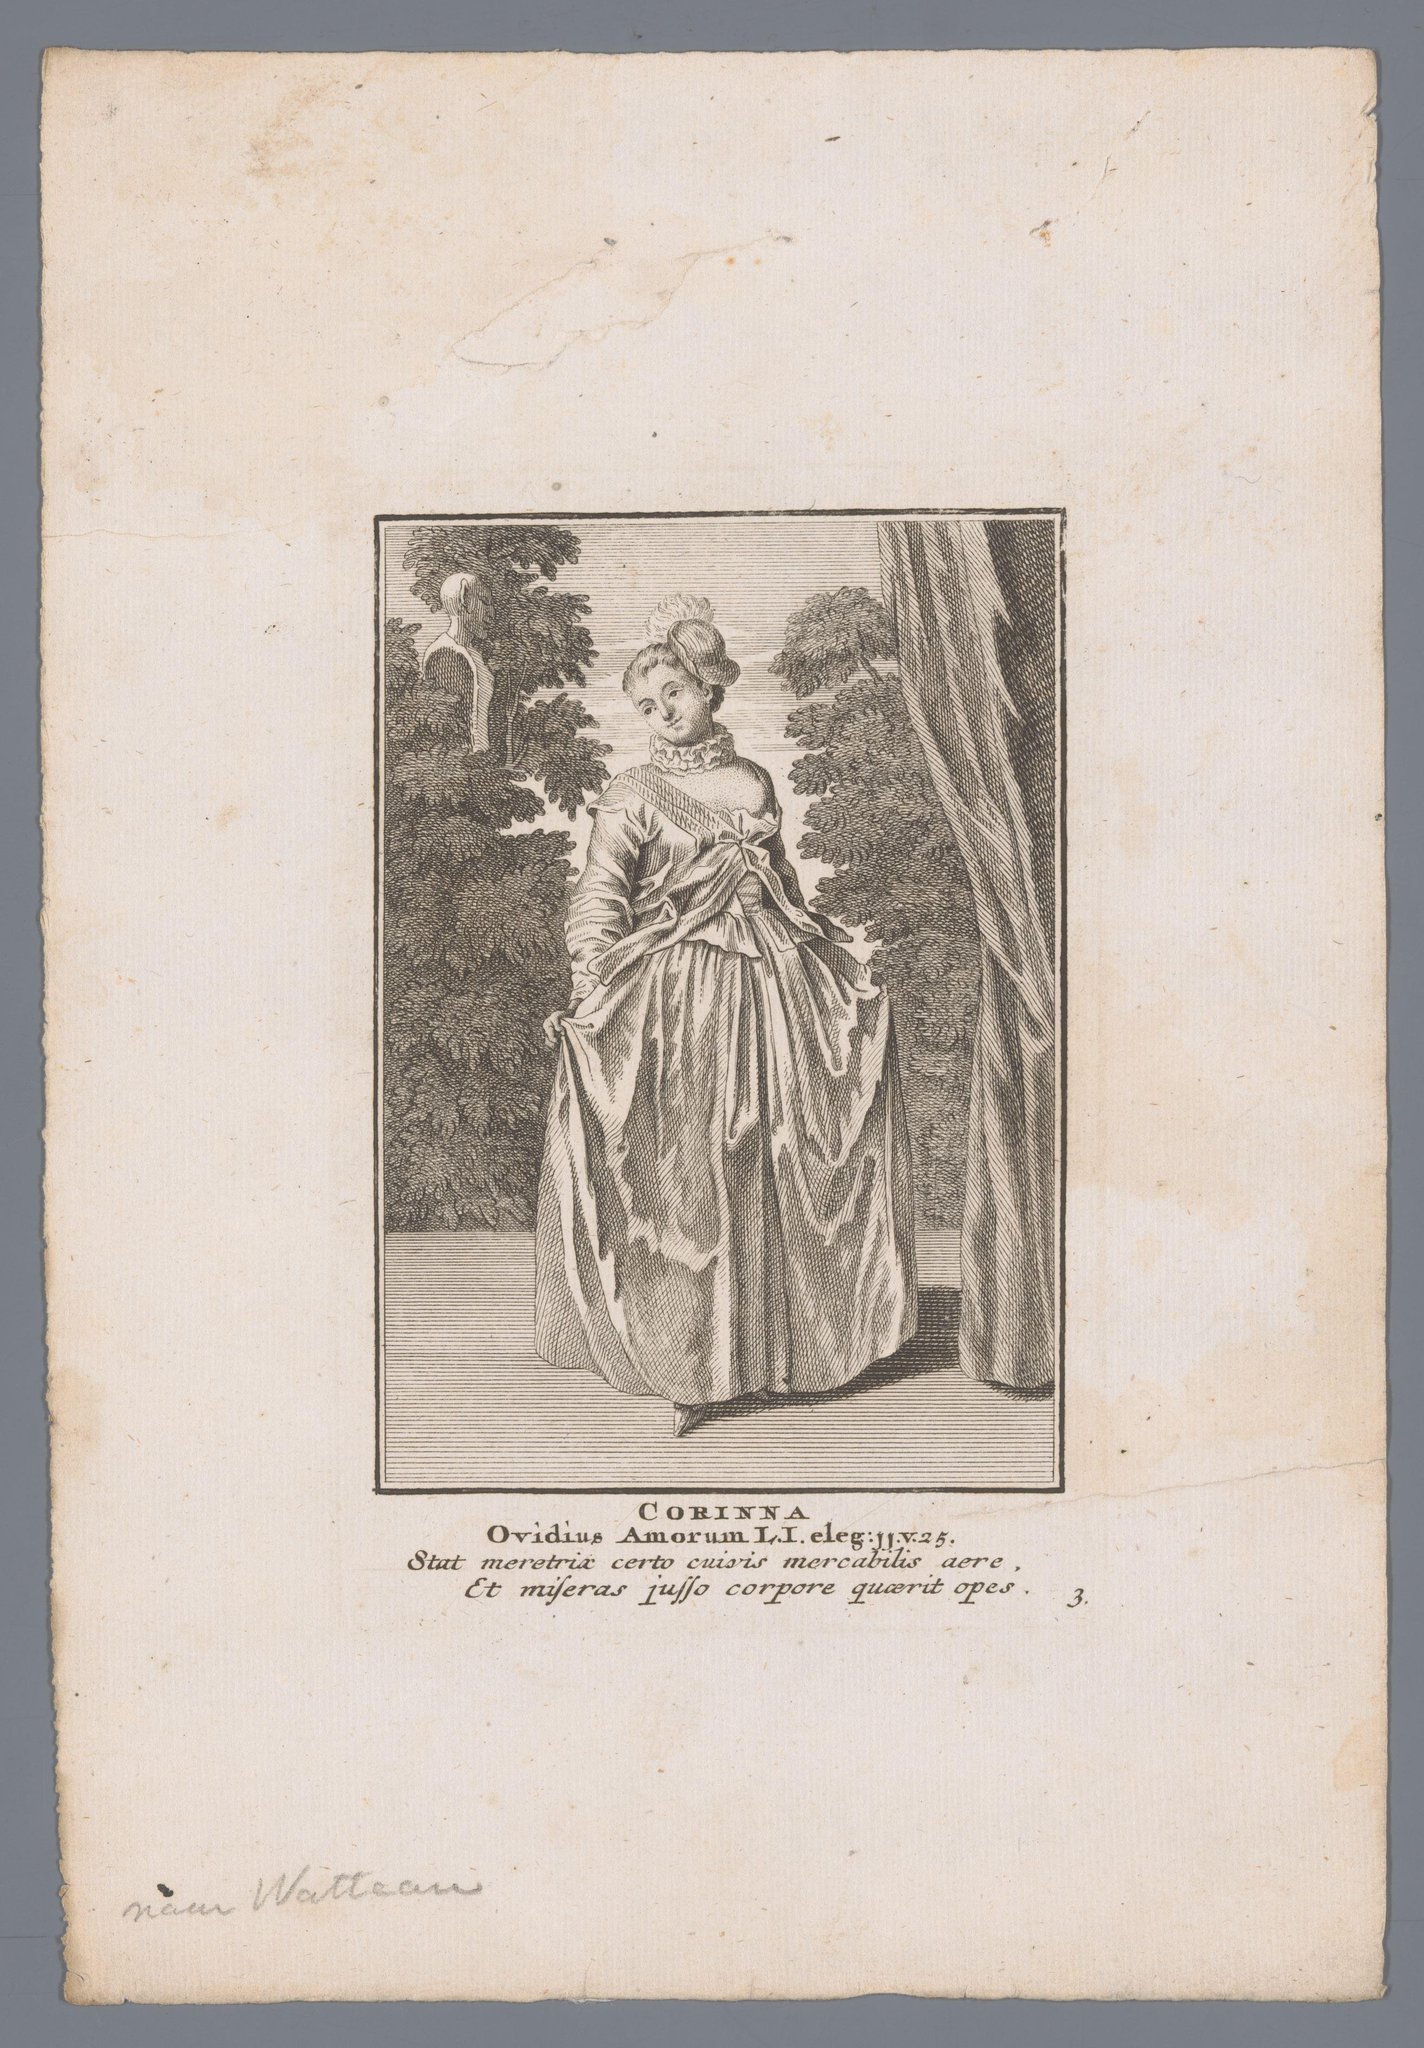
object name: print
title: Personages uit de Commedia dell'arte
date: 1694-1725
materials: paper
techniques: etching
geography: germany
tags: types in 'commedia dell'arte' (corinna), group of actors, troupe; actors on the stage, masquerade, masked ball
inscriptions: collector's mark: Lugt 2228